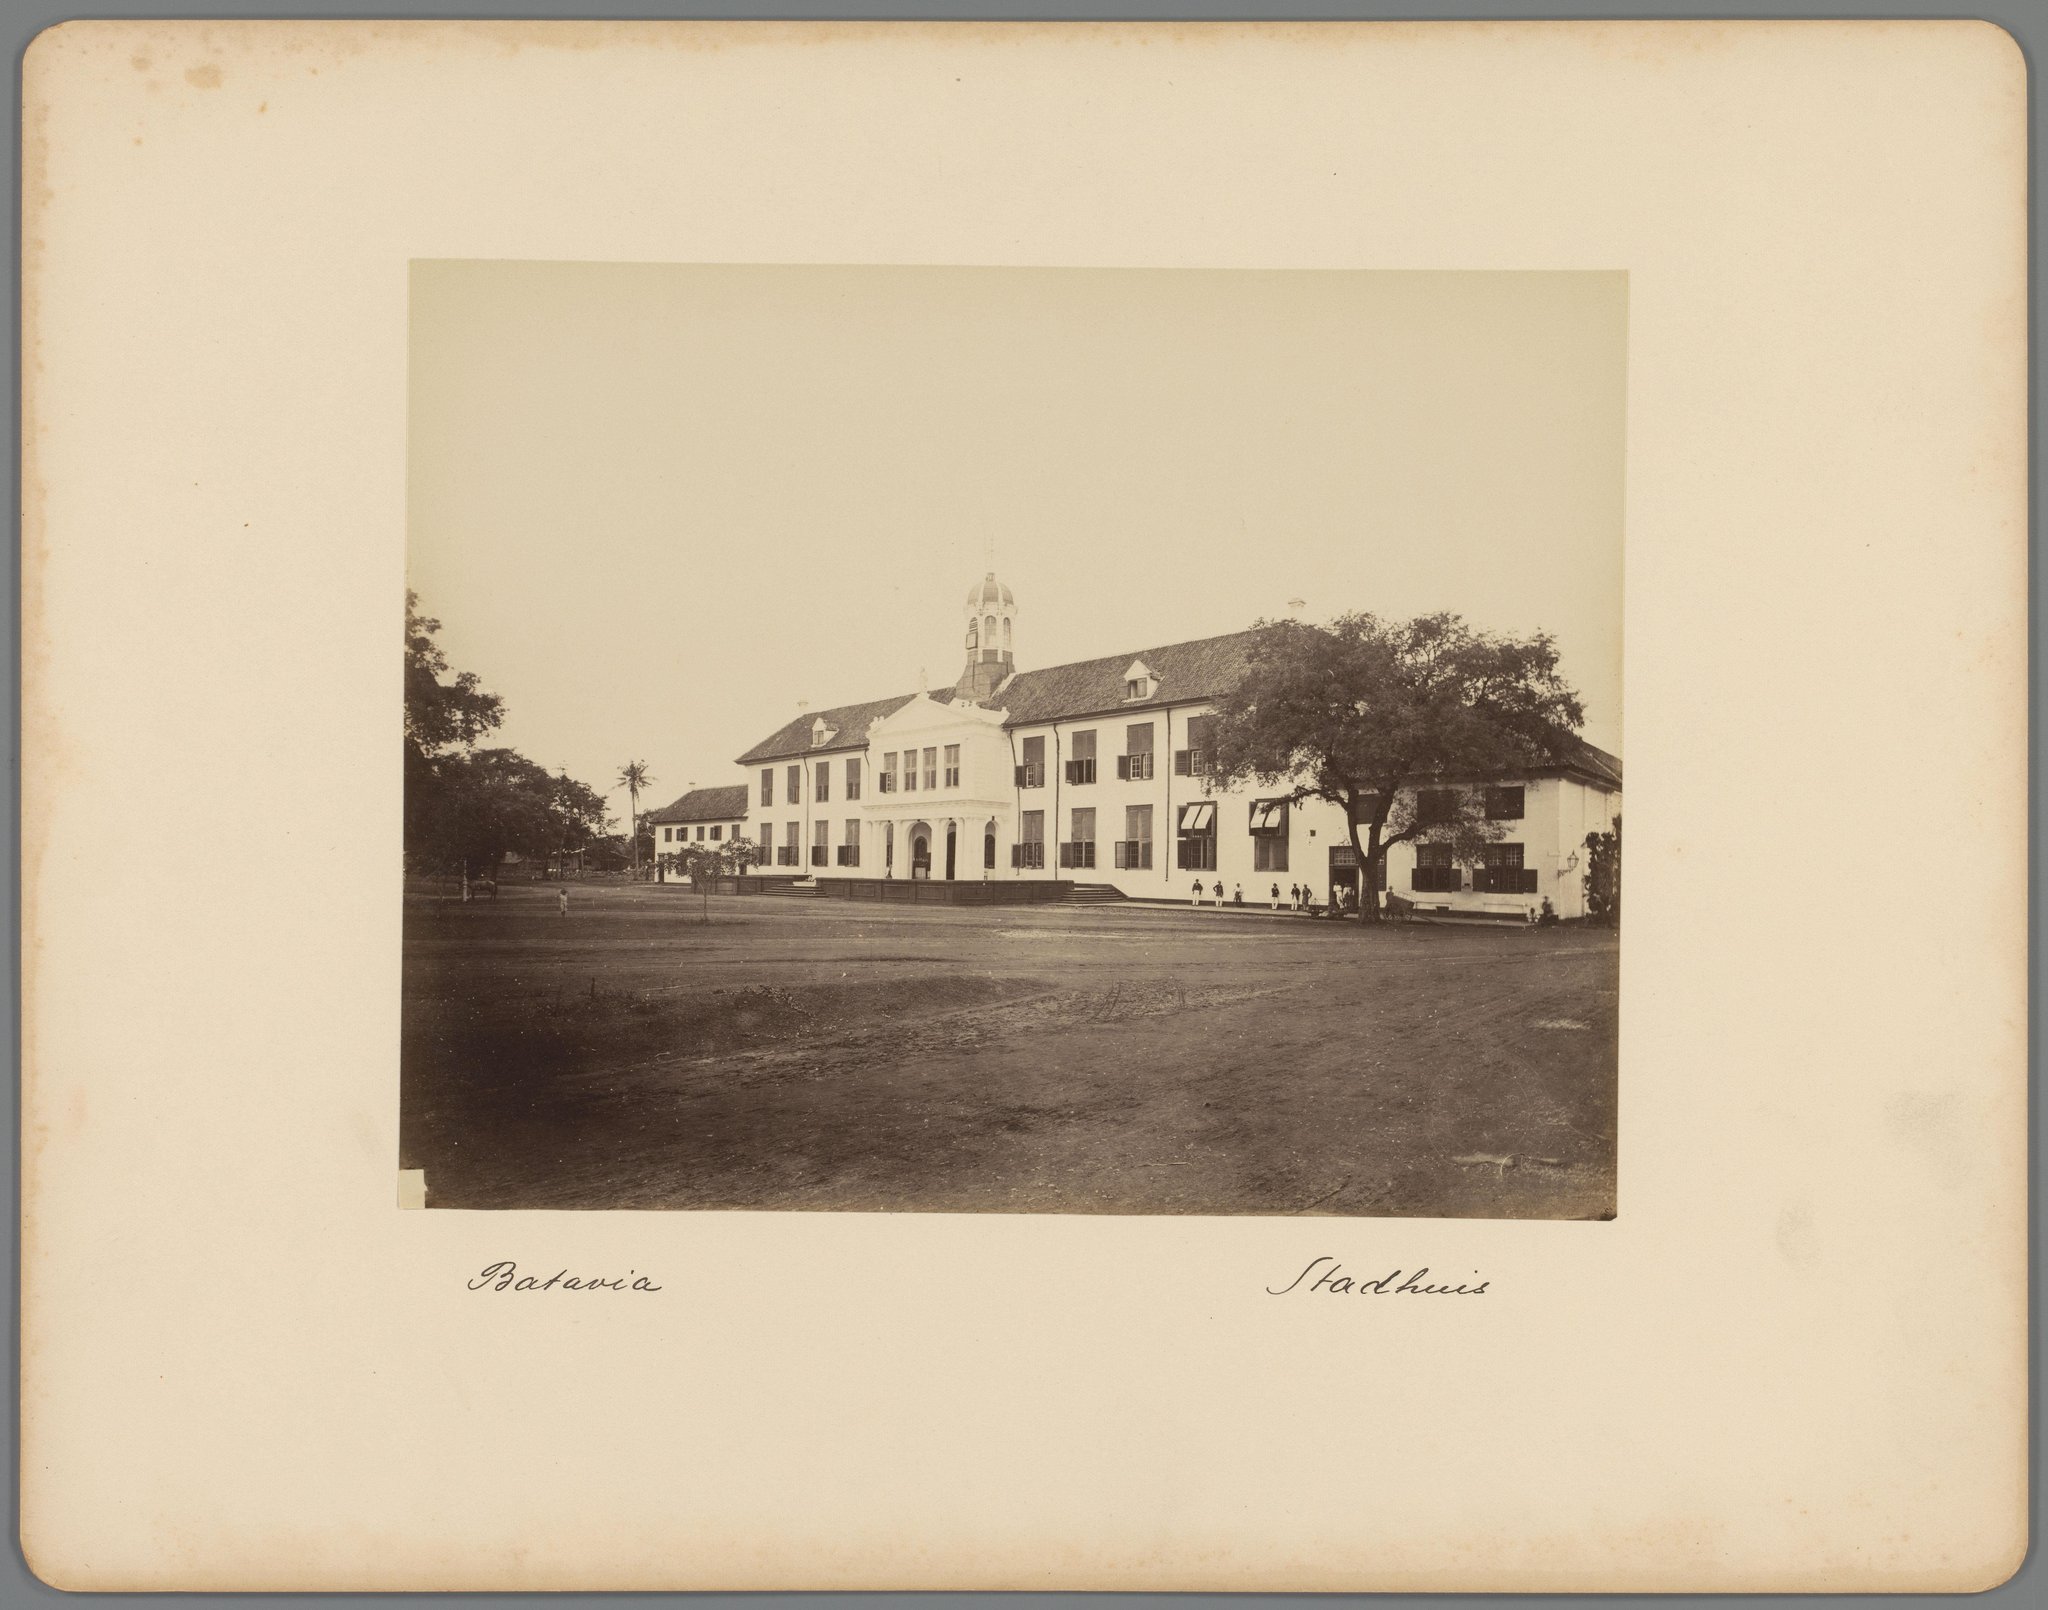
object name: photograph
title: Stadhuis van Batavia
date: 1880-1895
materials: cardboard, paper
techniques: albumen print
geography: batavia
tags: townhall, batavia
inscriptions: check stamp: ‘Photographieen van Ned. Indië/ W & P/ Batavia’, inscription: ‘Foto’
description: Deze foto zat oorspronkelijk in prentenkabinet RP-F-AA3192.